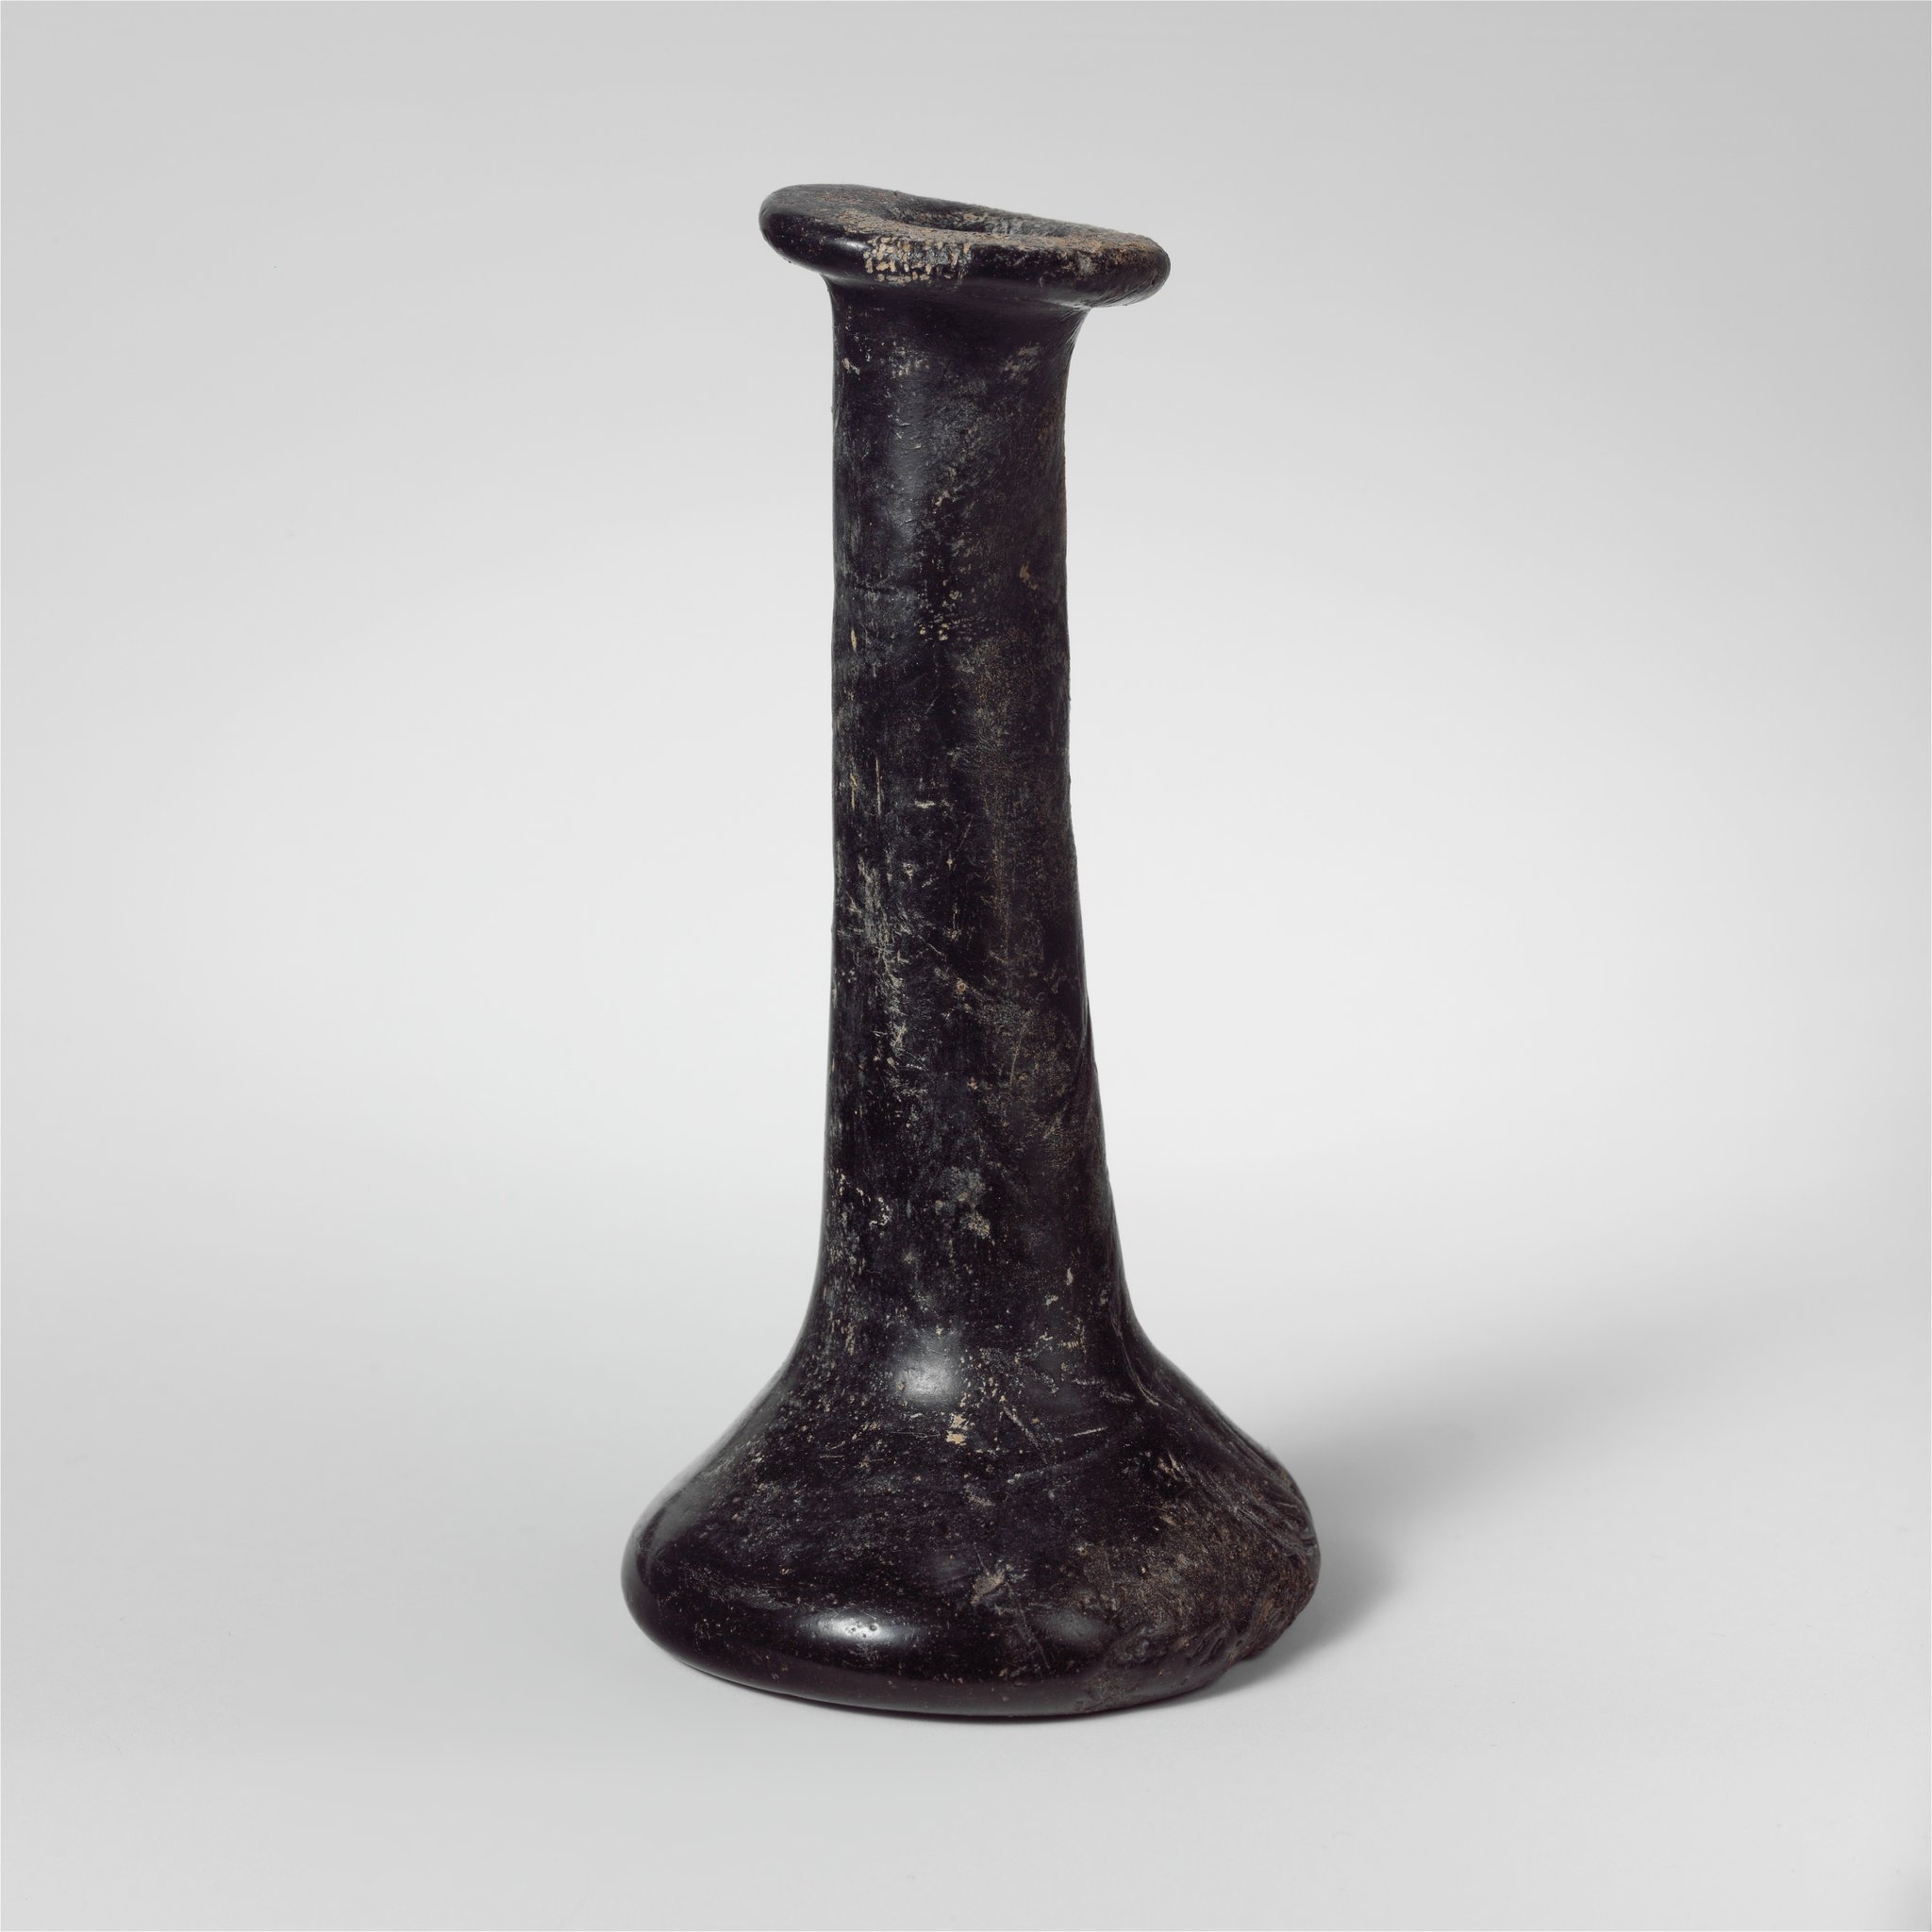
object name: perfume bottle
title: Glass perfume bottle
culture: roman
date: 101-400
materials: glass